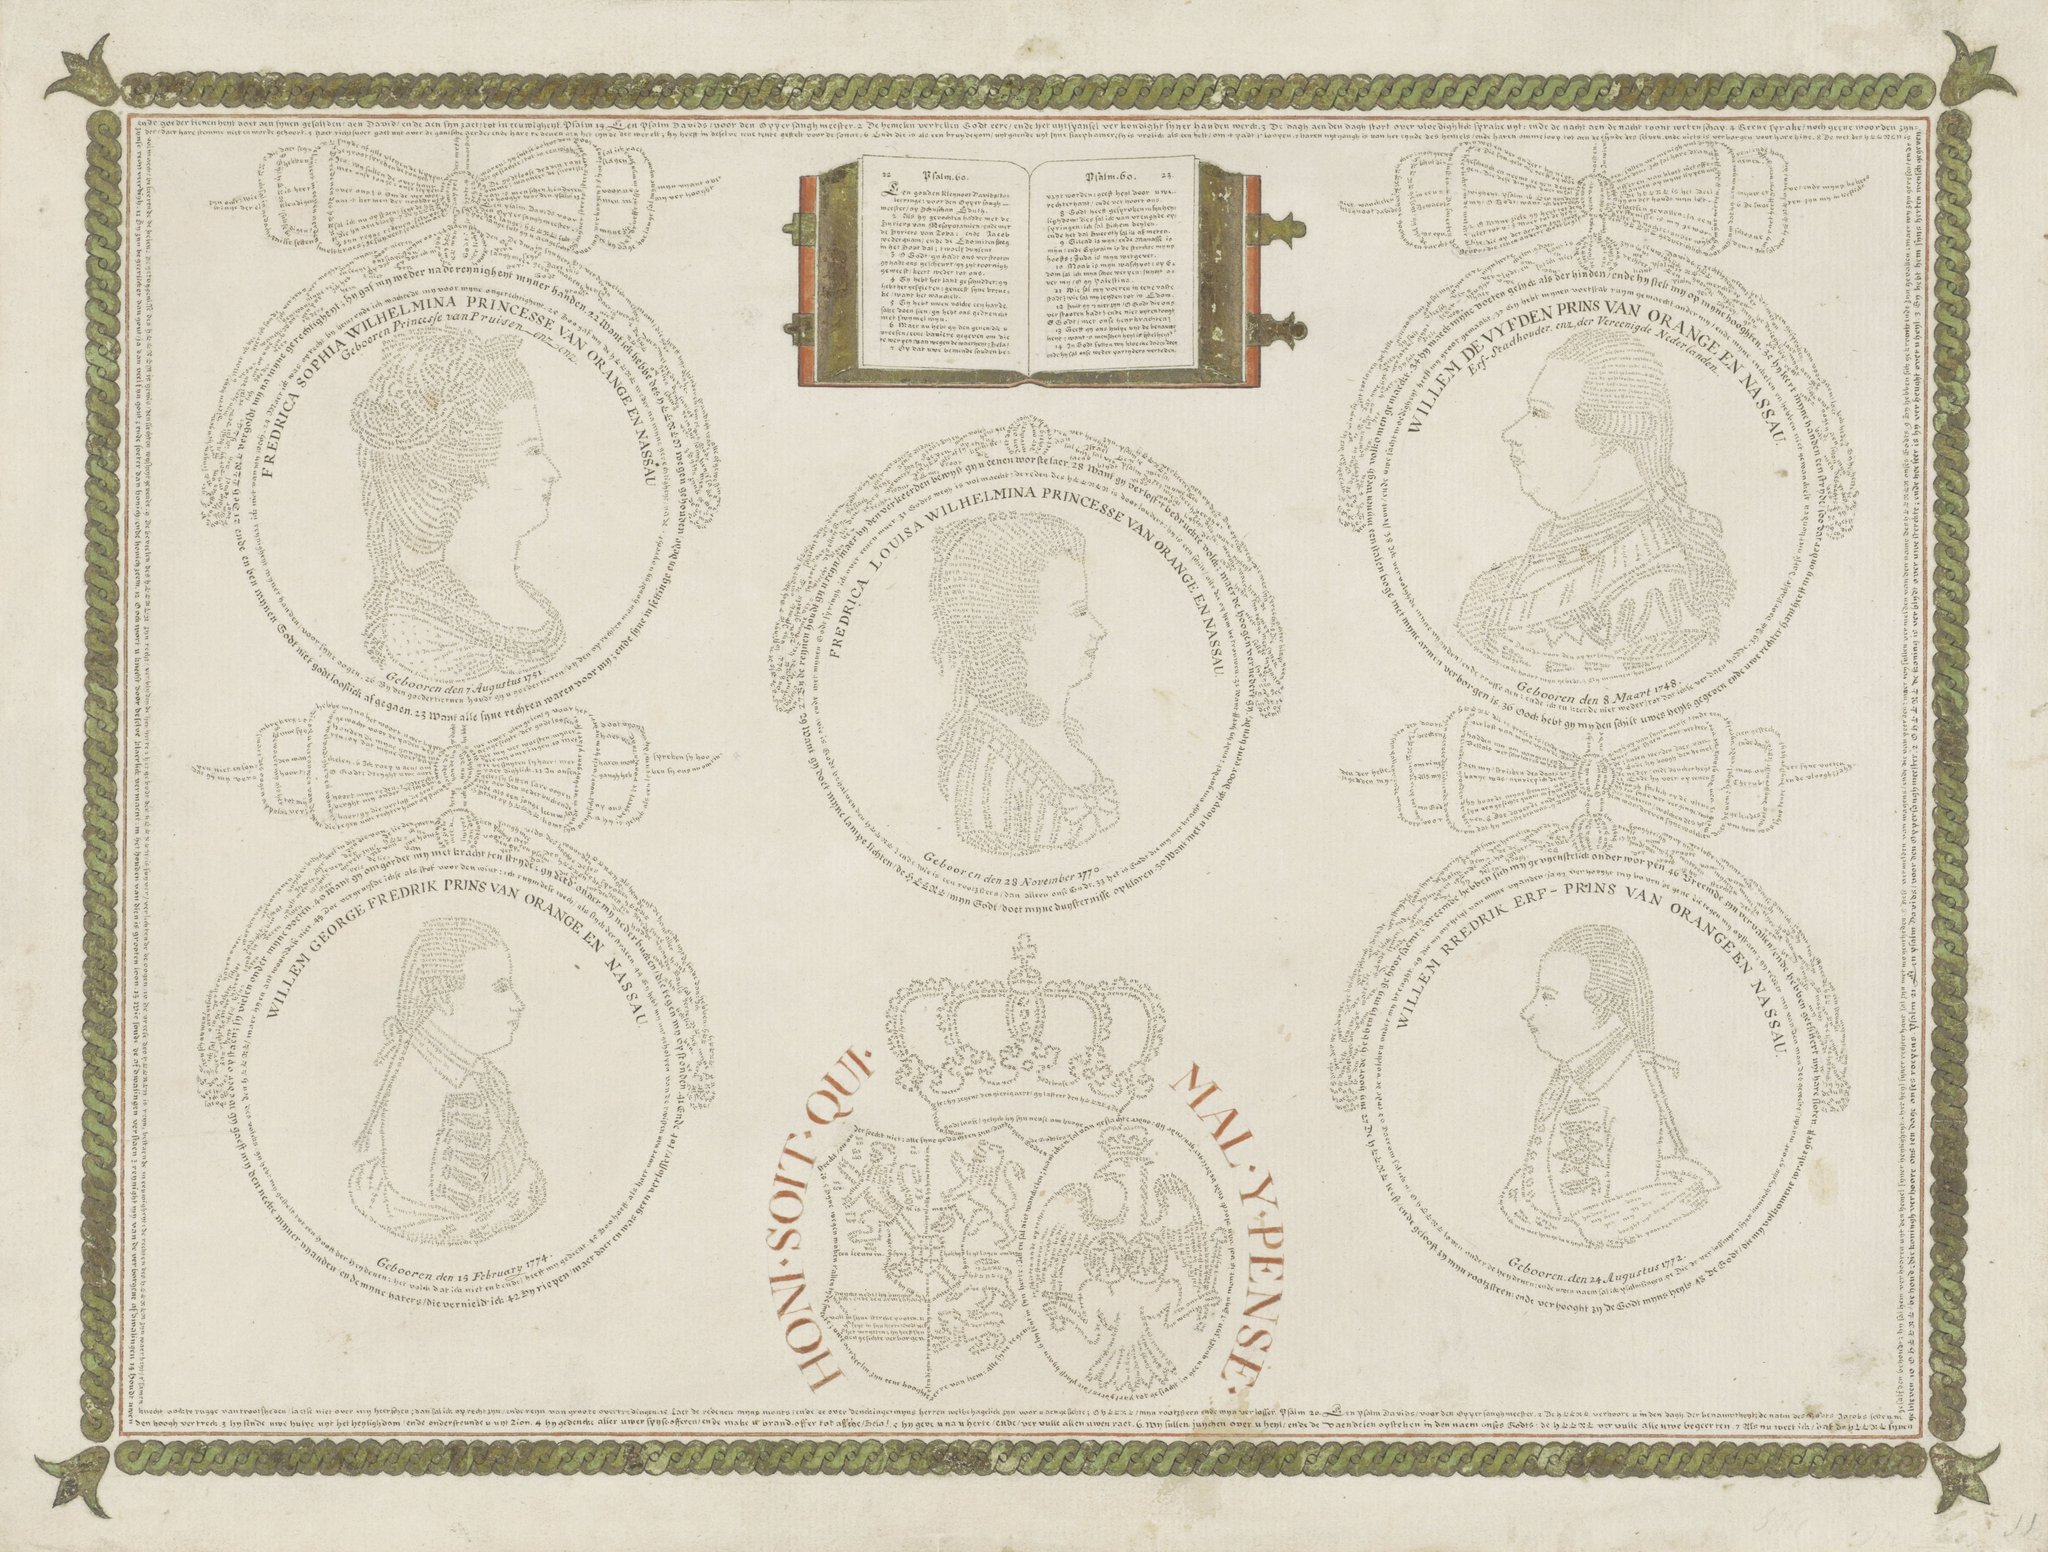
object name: drawing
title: Portretten van Wilhelmina van Pruisen, Willem V, prins van Oranje-Nassau, Louise, prinses van Oranje-Nassau, Frederik, prins van Oranje-Nassau, en Willem I Frederik, koning der Nederlanden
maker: Anonymous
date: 1780-1849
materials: ink, paper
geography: low countries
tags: william v (prince of orange), the hague, berlin, william i of the netherlands, painter, draughtsman, wilhelmina of prussia (princess of orange), amsterdam, louise (prinses van oranje-nassau), willem george frederik (prins van oranje-nassau), knighthood order (garter) - insignia of a knighthood order, e.g.: badge, chain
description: Portretten van Wilhelmina, Willem V, Louise, Frederik en Willem I Frederik. Elk in een cirkel met randschrift en midden boven een lint met een strik. Midden onder twee wapens met een kroon, gedecoreerd met het devies van de Orde van de Kousenband. Midden boven een opengeslagen Bijbel. Geheel in een geornamenteerde omlijsting. De gehele tekening is uit letters samengesteld; alle lijnen in de tekening zijn regels uit de Psalmen.